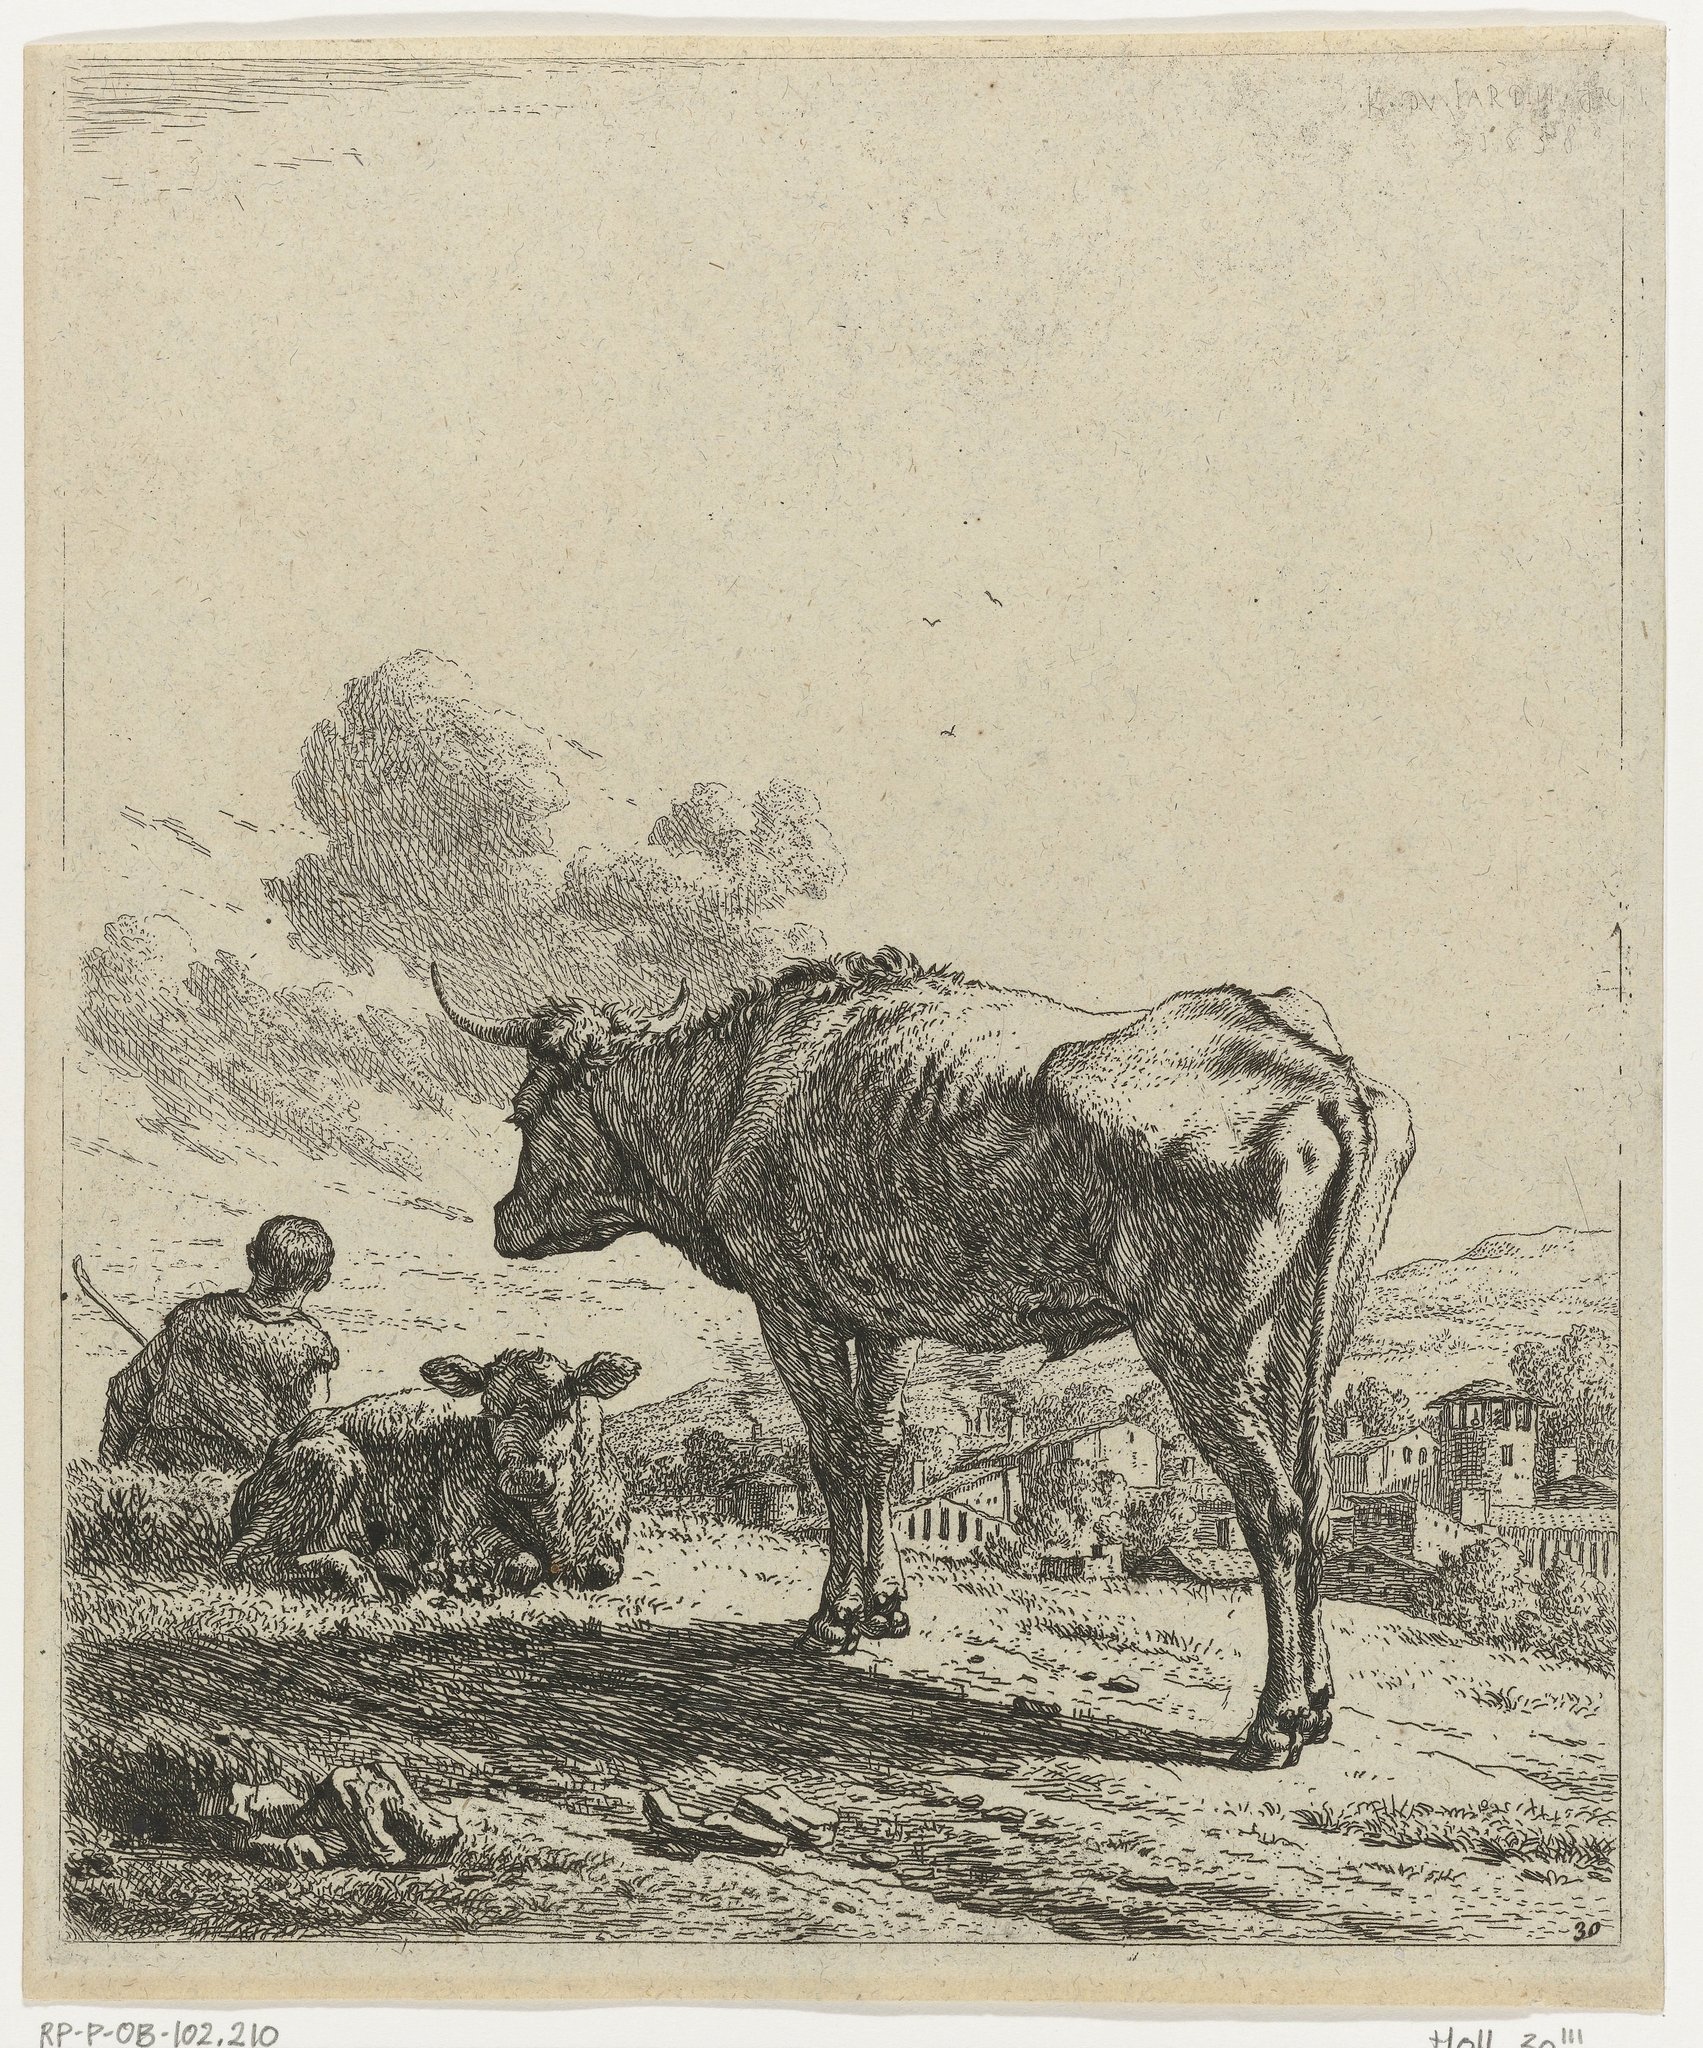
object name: print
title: Herder met een os en kalf bij een dorp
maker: karel du jardin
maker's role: draughtsman, painter, print maker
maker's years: 1626-1678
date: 1658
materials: paper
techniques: etching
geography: the hague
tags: calf, ox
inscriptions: collector's mark: Lugt 2228